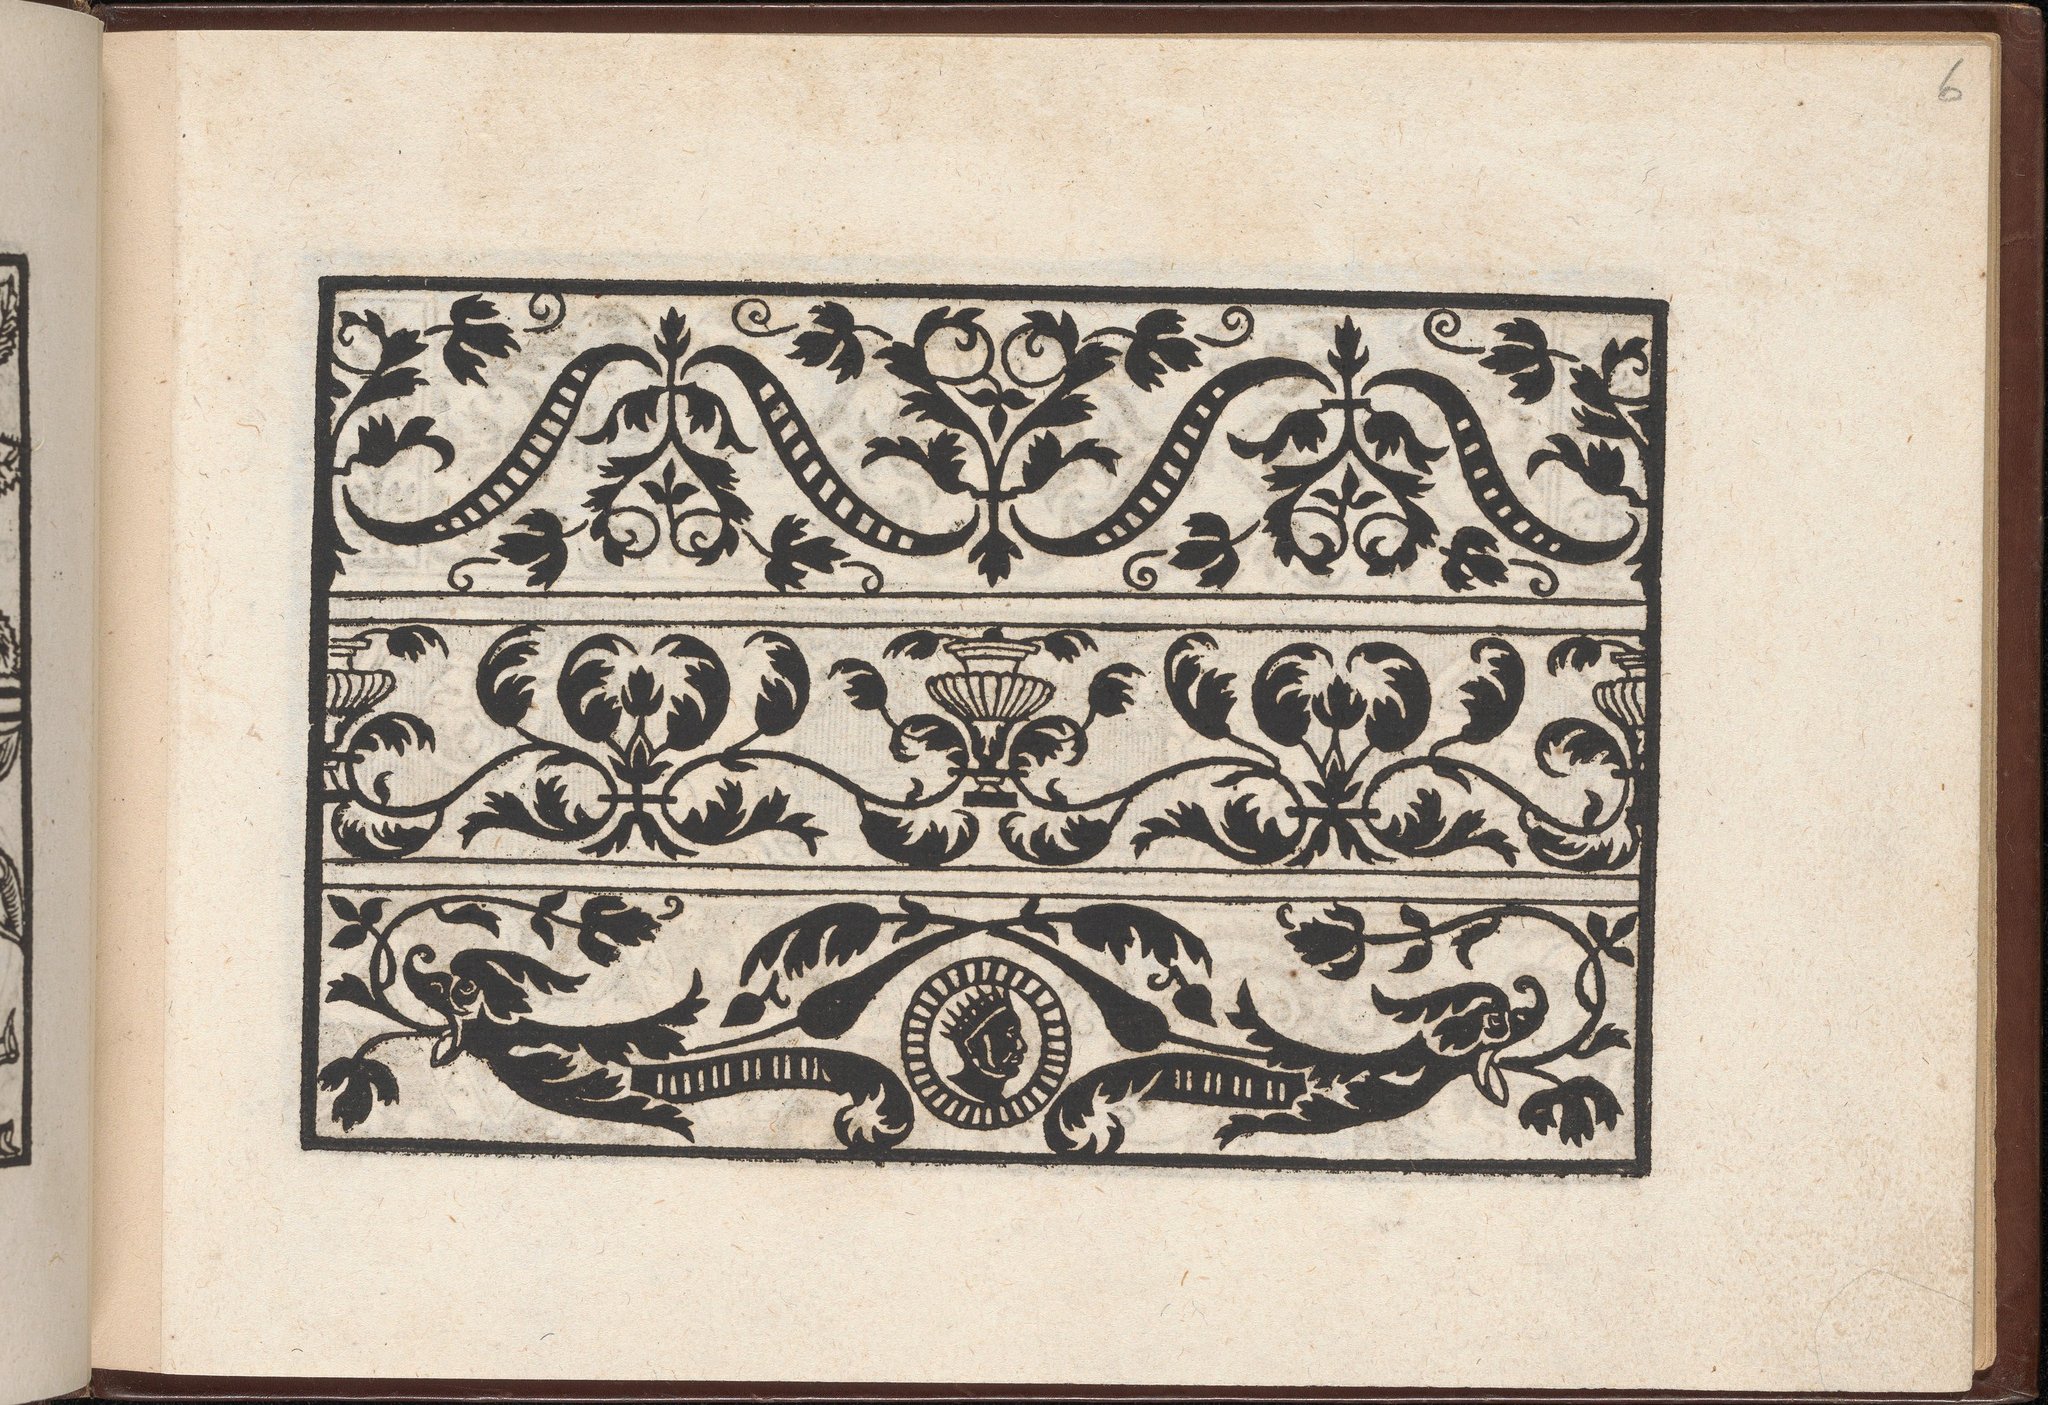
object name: book print ornament architecture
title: Page from Eyn Newe kunstlich moetdelboech alle kunst (Page 6r)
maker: peter quentel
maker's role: publisher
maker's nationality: german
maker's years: 1500-1550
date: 1532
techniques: woodcut